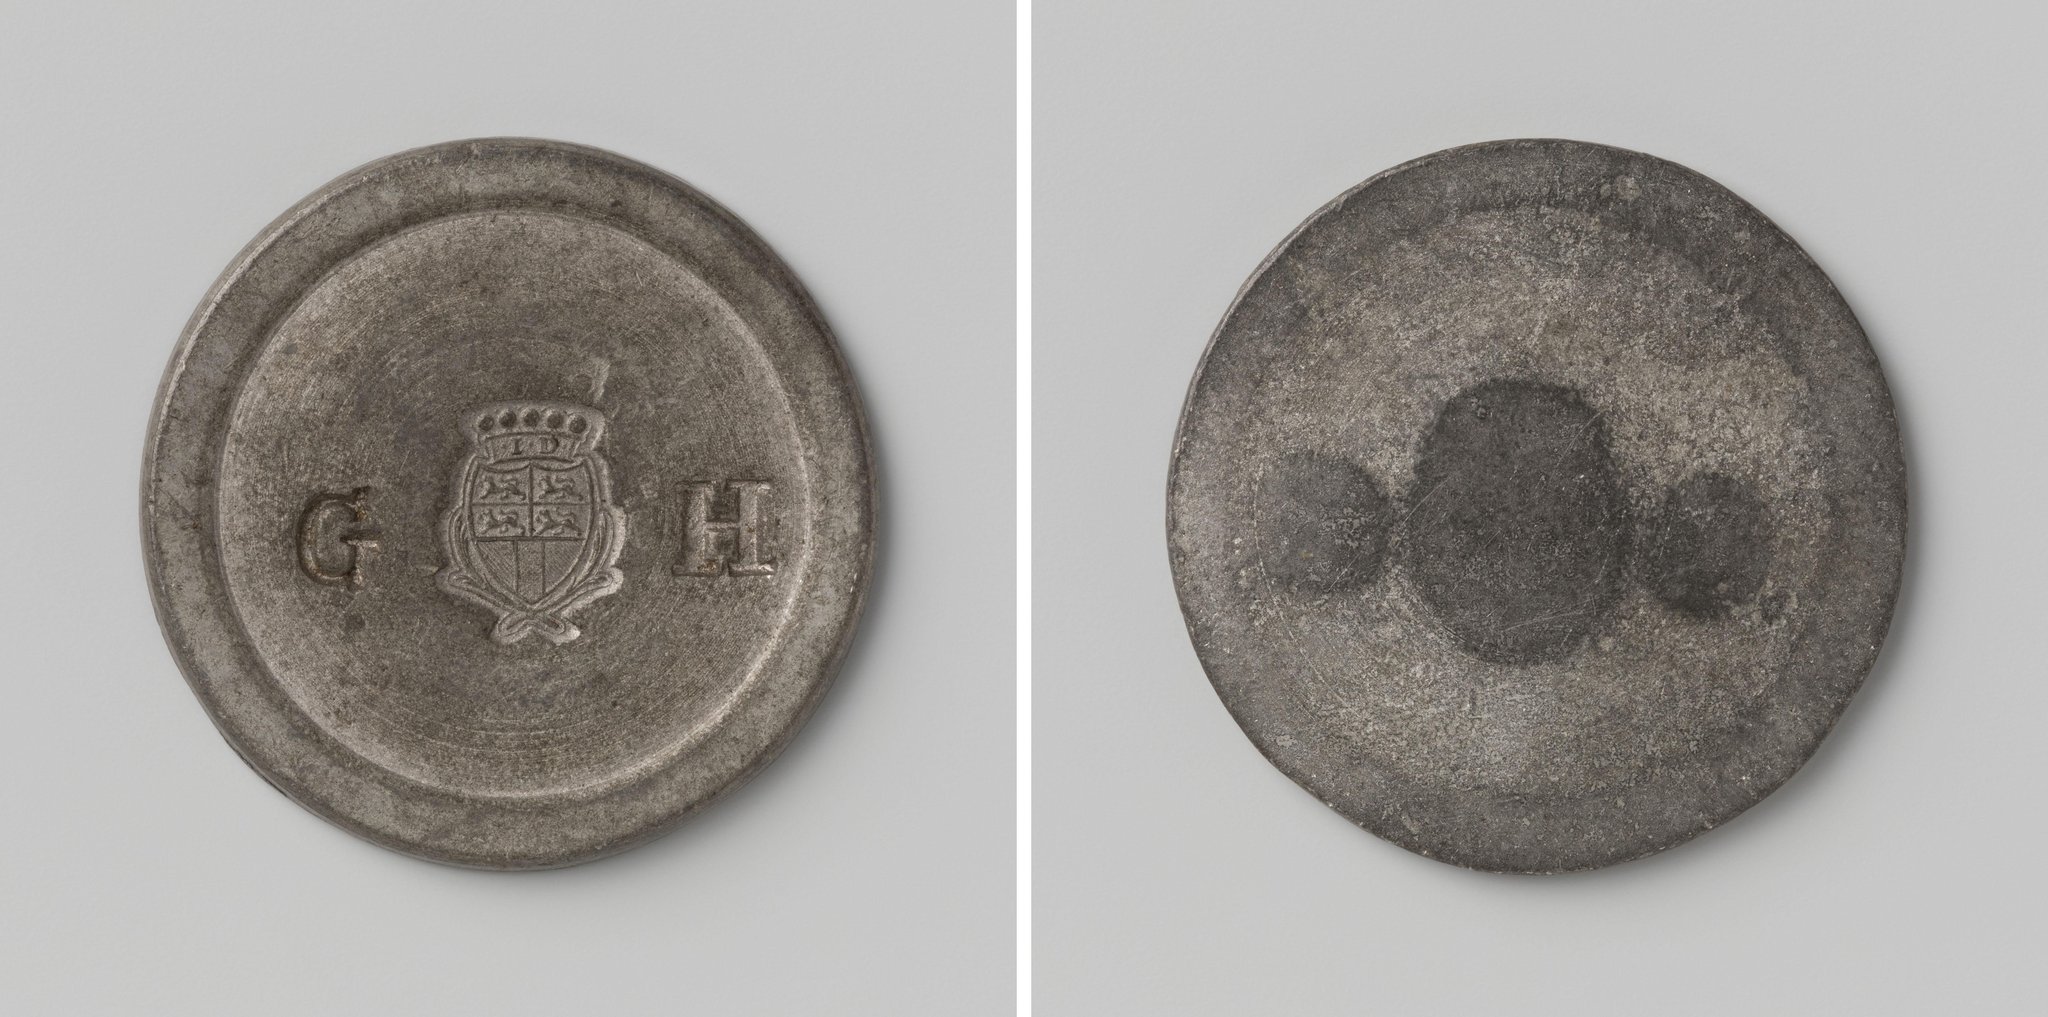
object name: toegangspenning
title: Gasthuis te Rotterdam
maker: Anonymous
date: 1600-1800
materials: lead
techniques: striking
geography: rotterdam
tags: rotterdam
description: Eenzijdige loden penning. Voorzijde: twee stempels: gekroond wapenschild op twee bladertakken, tussen letters G en H. Keerzijde: blanco